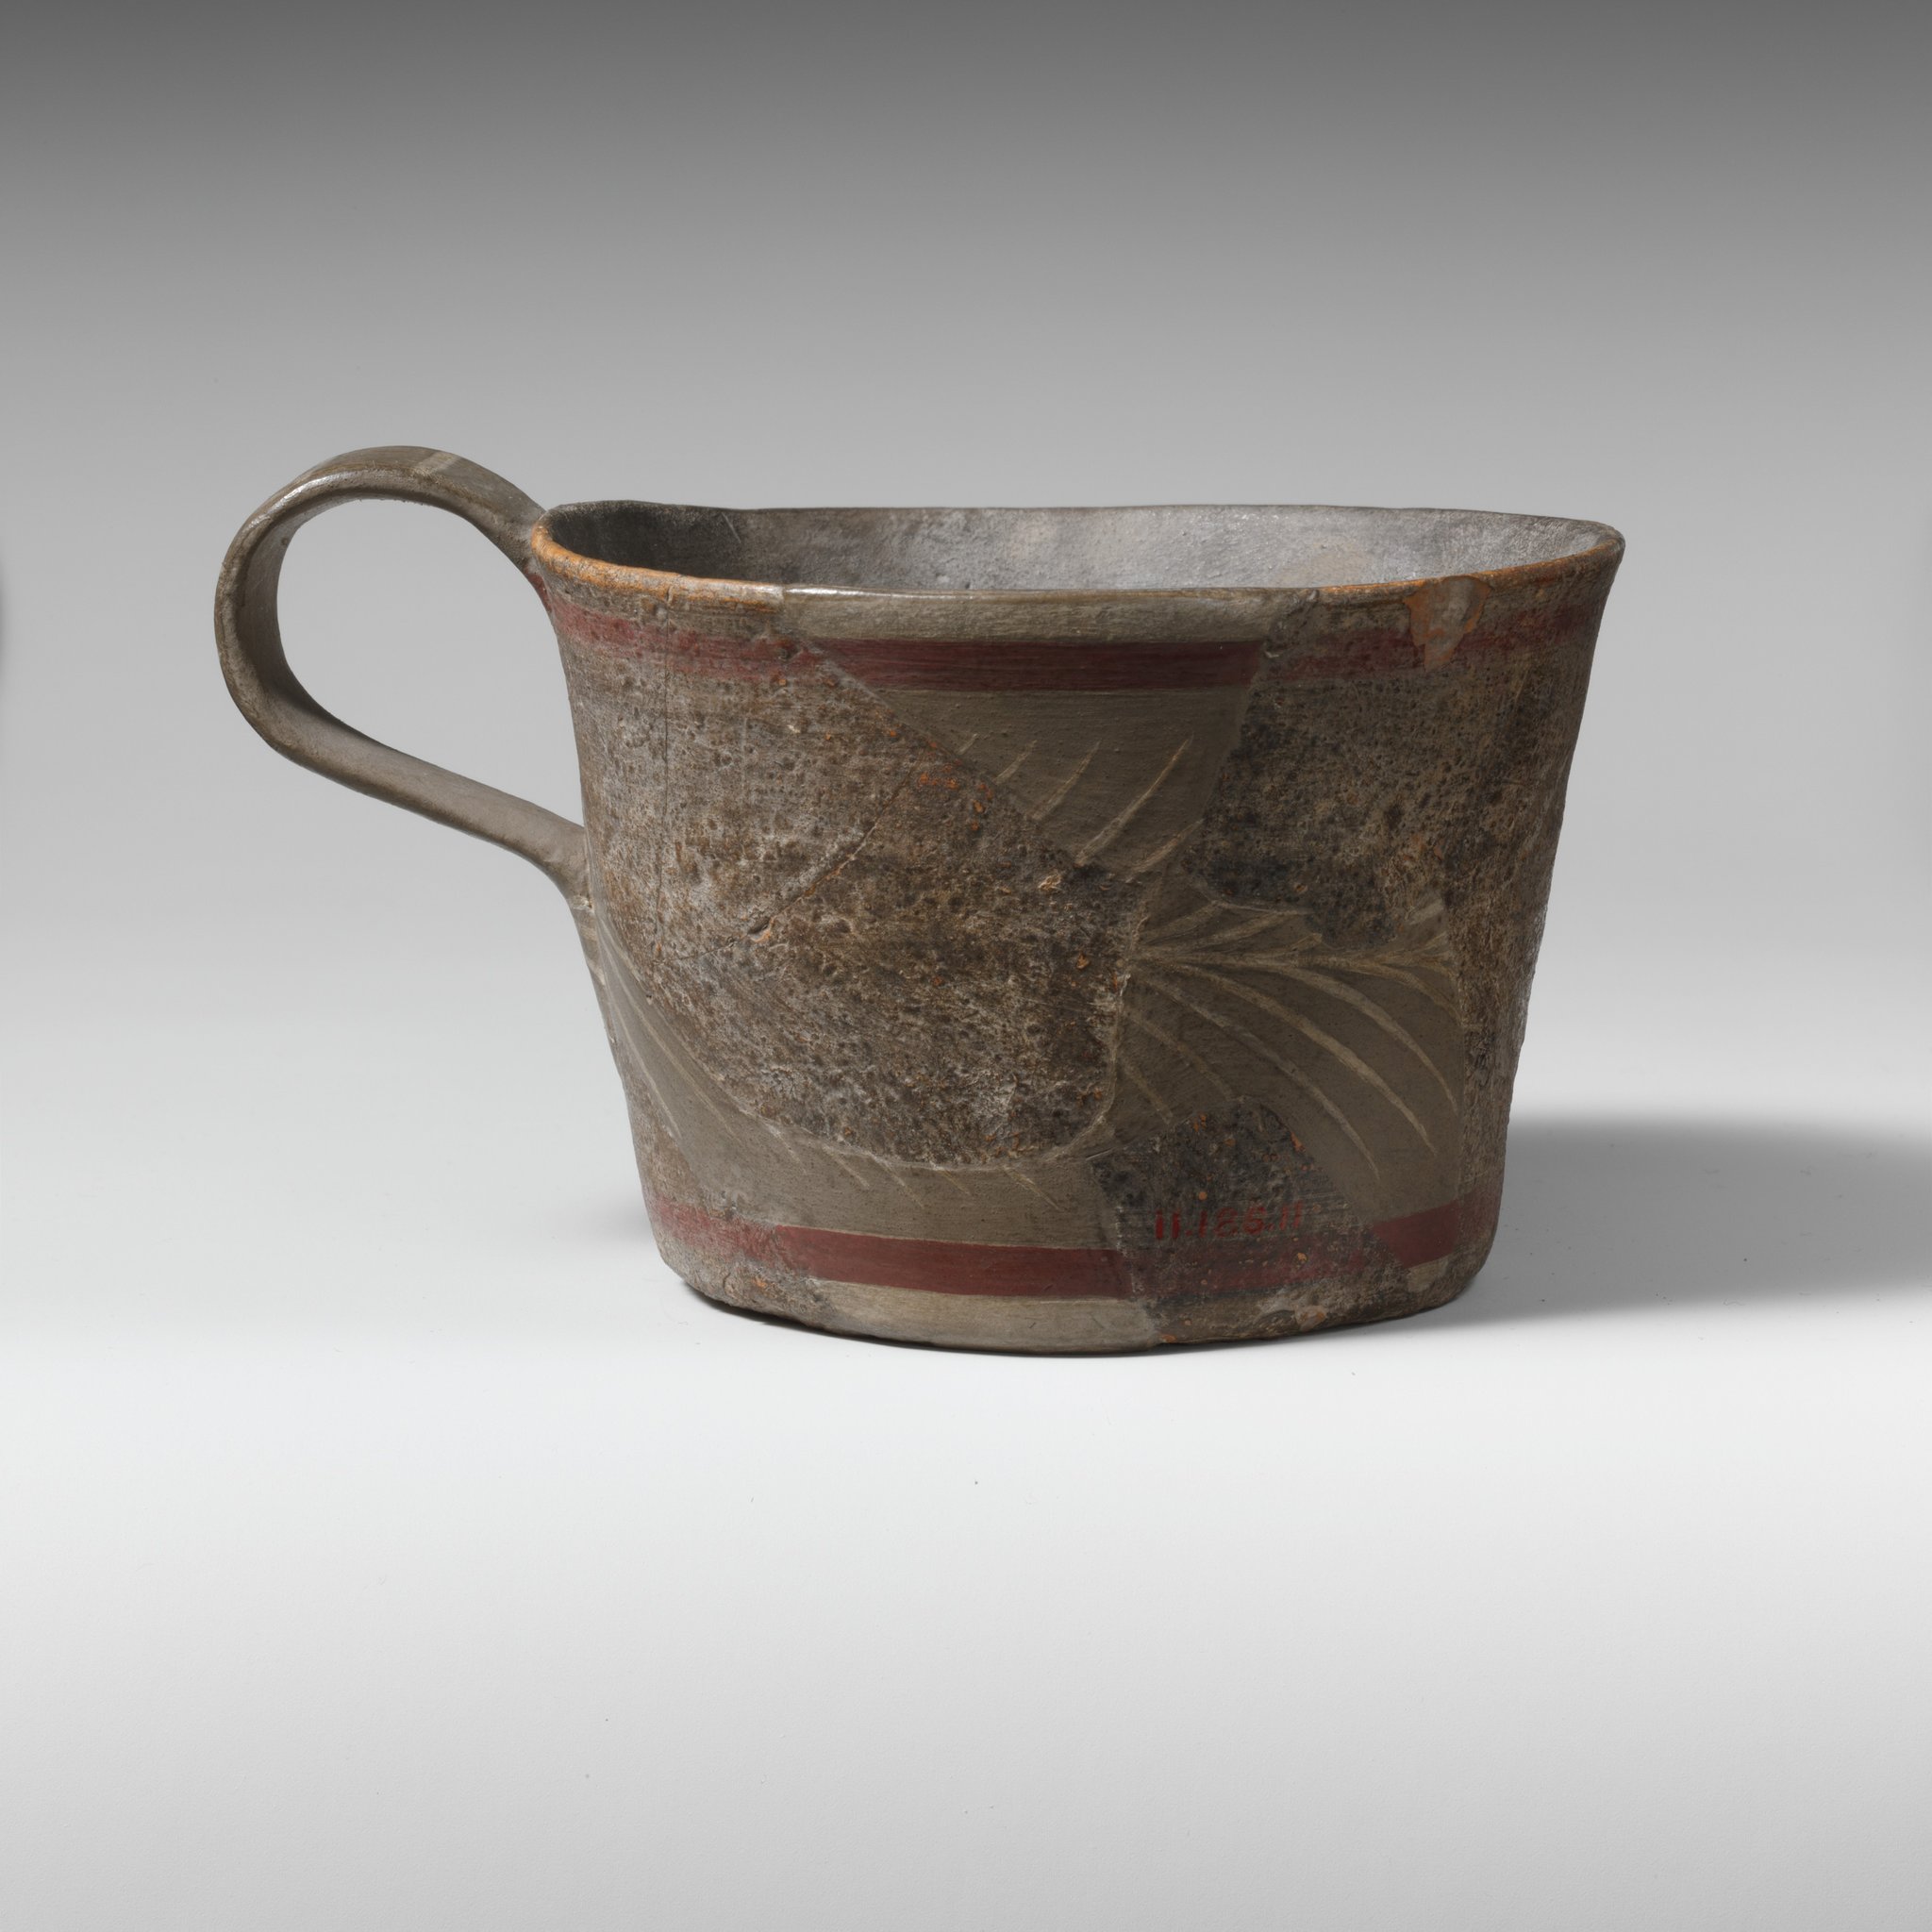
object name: cup, one handled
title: Terracotta straight-sided cup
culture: minoan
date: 1750-1700 BCE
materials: terracotta